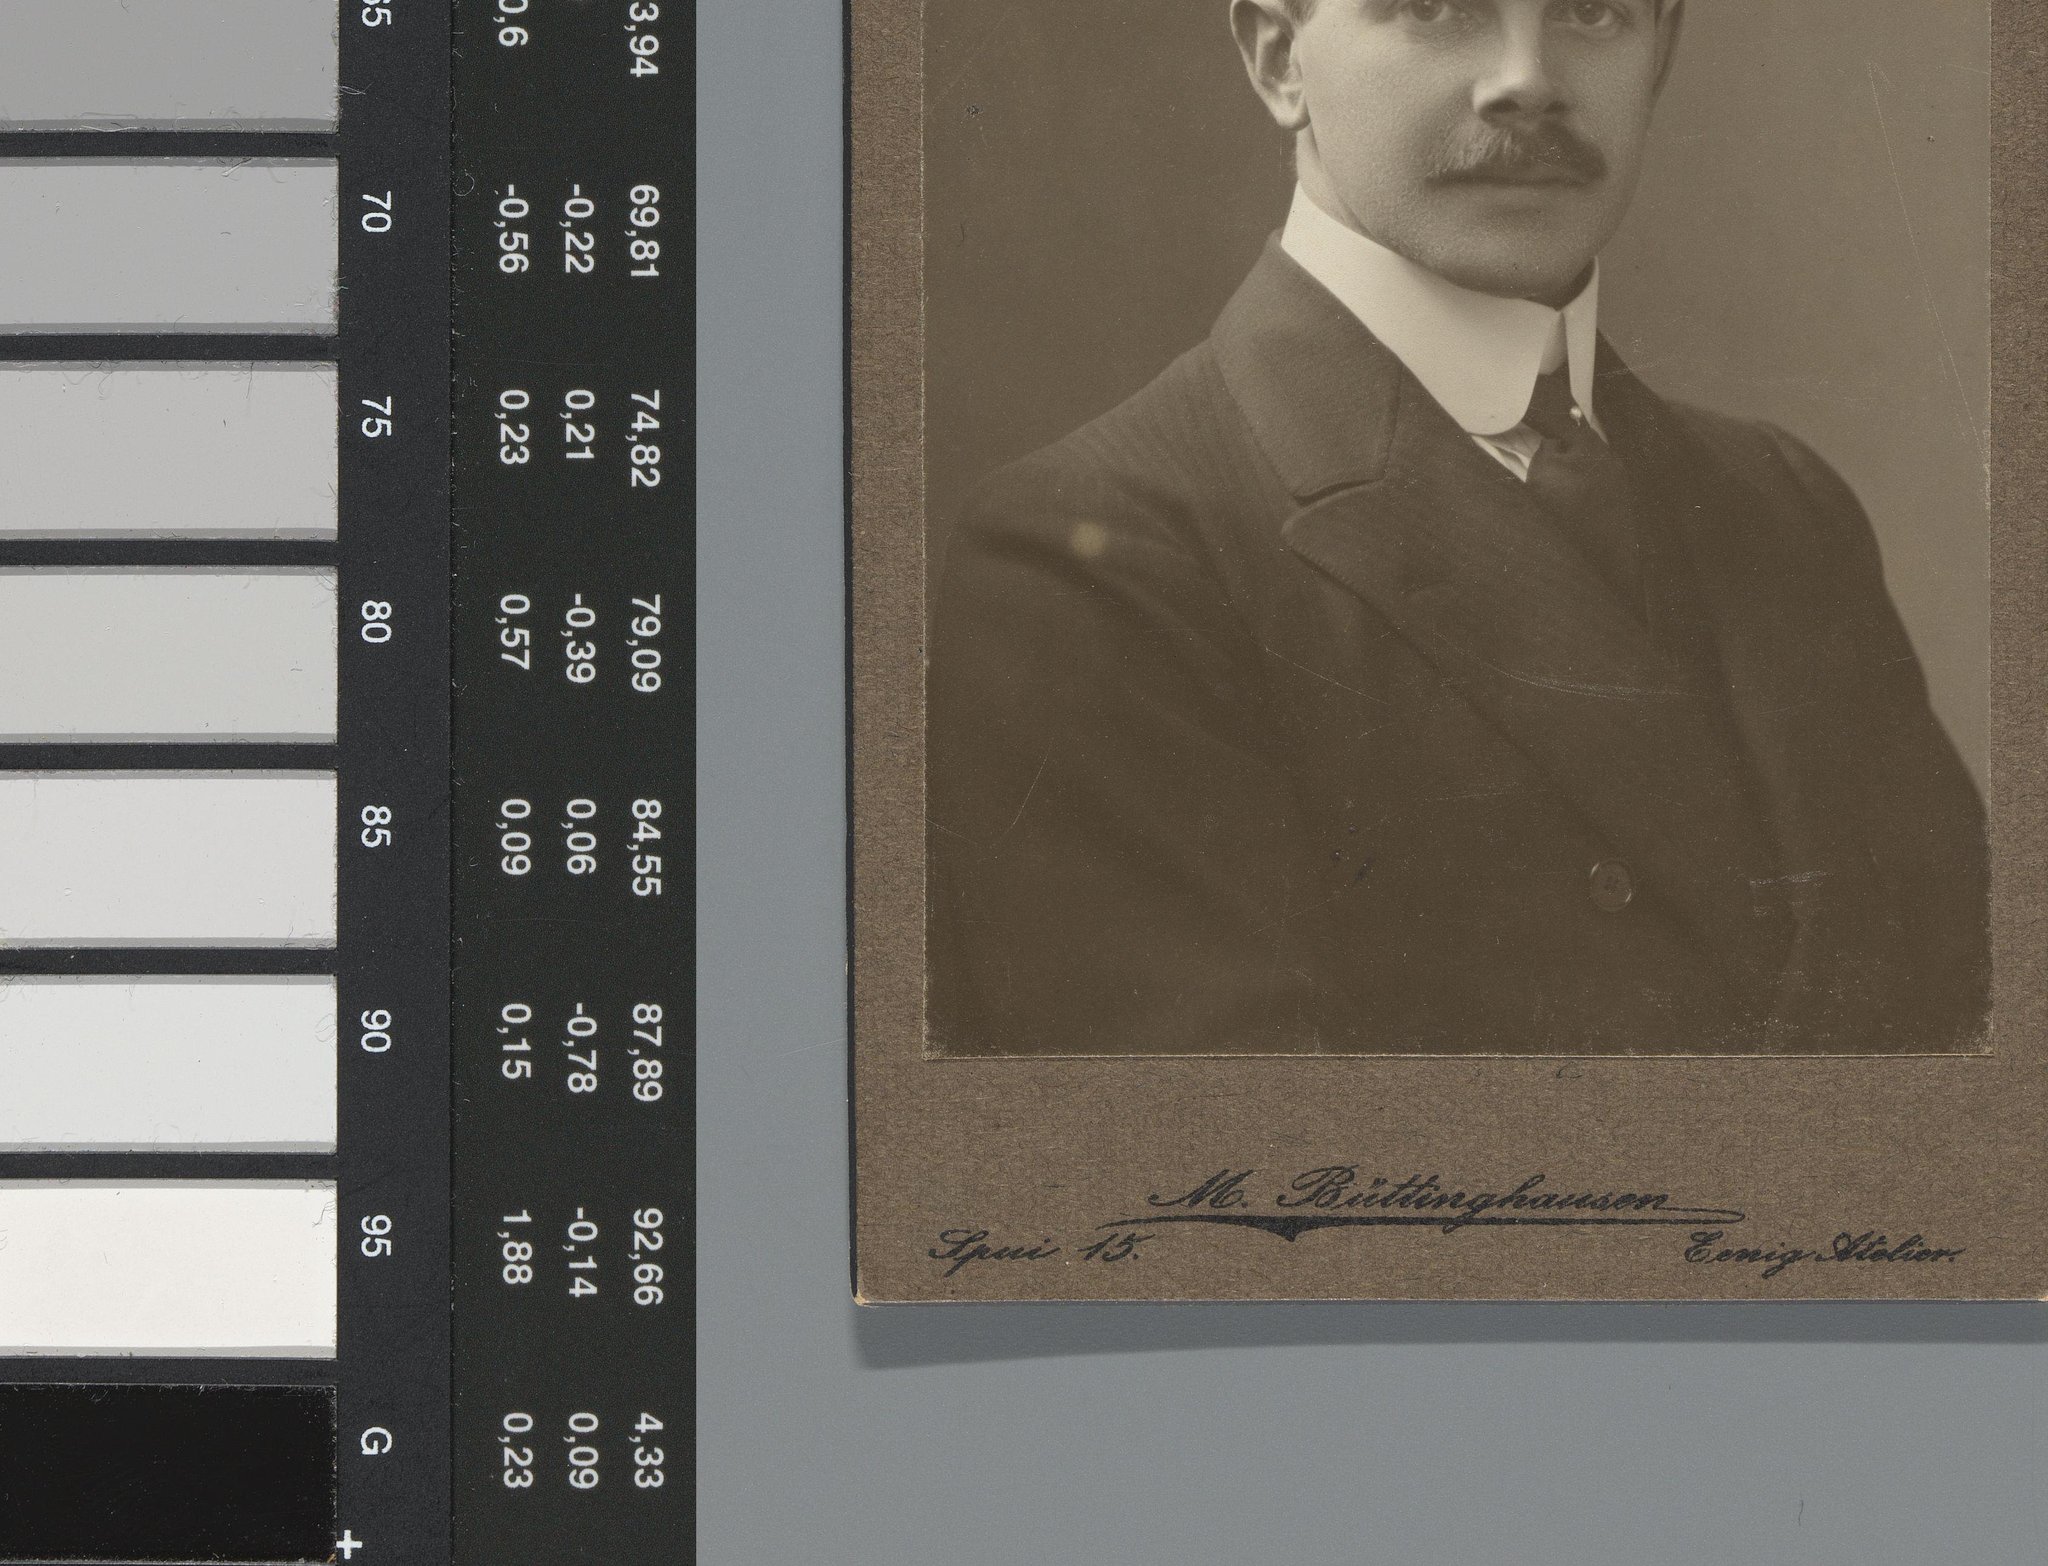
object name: carte de visite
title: Portret van Hendrik Herman van den Berg (Henk)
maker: max büttinghausen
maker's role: fotograaf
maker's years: 1847-1906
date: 1910-1930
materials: cardboard, photographic support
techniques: albumen print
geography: amsterdam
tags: batavia, amsterdam, hendrik herman van den berg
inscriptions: inscription: ‘Spui 15. / M. Büttinghausen / Eenig Atelier’